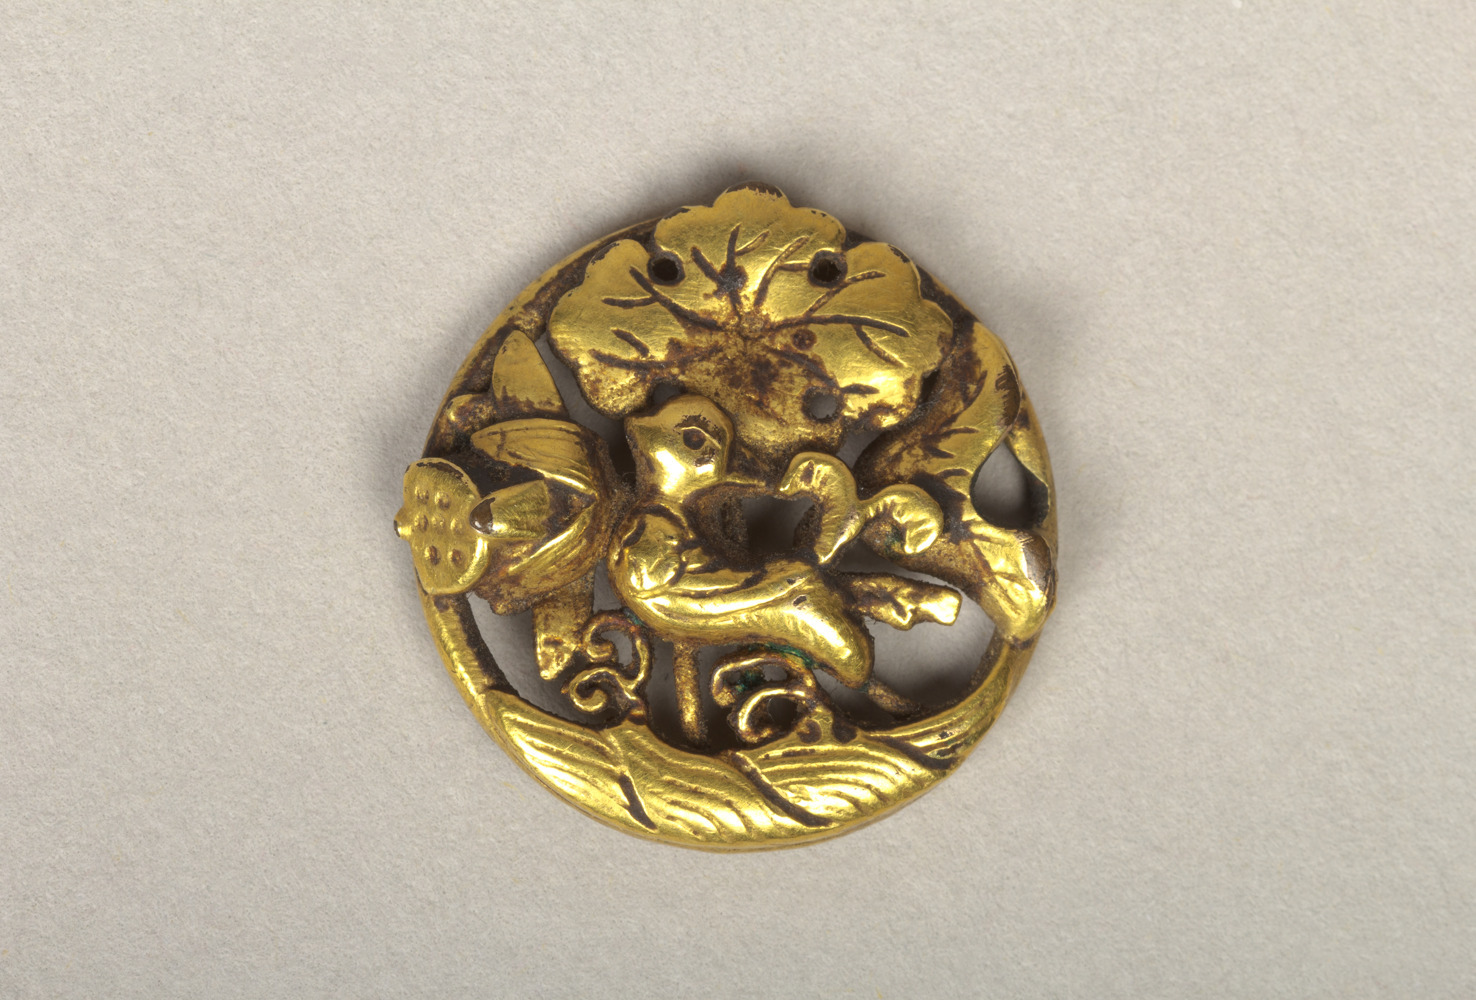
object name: ornament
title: Ornament with bird among lotuses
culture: korean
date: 918-1392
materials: gold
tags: birds